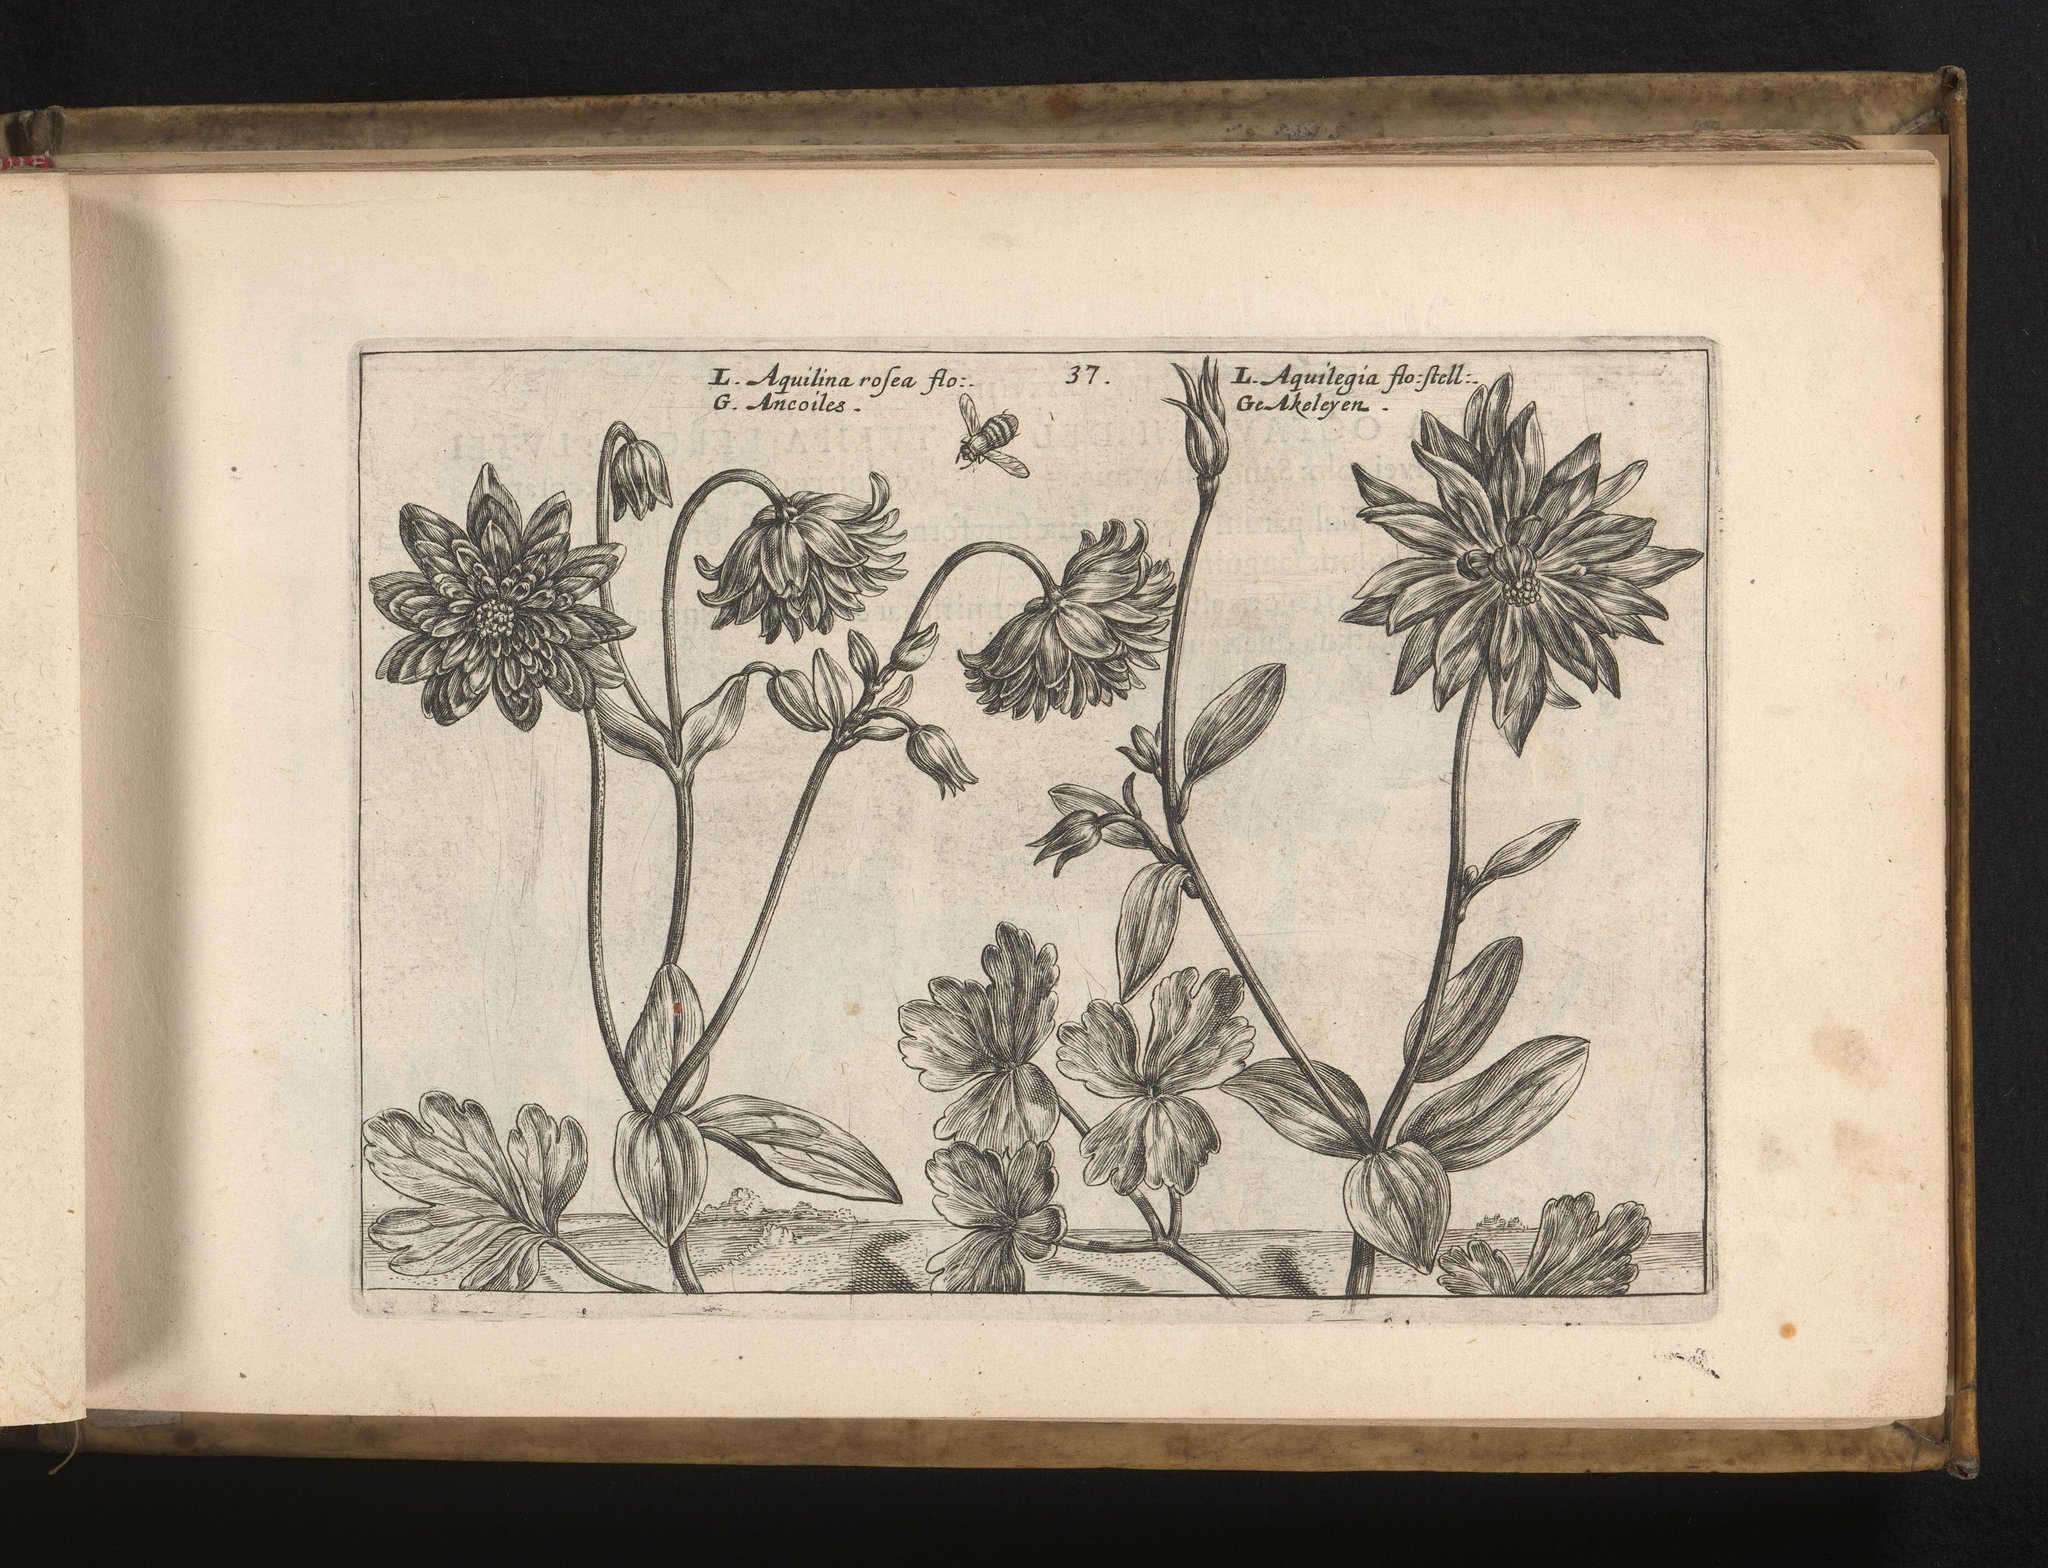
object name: print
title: Bloementuin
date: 1617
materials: paper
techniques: engraving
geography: utrecht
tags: flowers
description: Prent uit: Passe, Crispijn van de (II). Hortus floridus in quo rariorum & minus vulgarium florum icones ad vivam veramque formam. Arnhem: Johannes Janssonius, 1617.